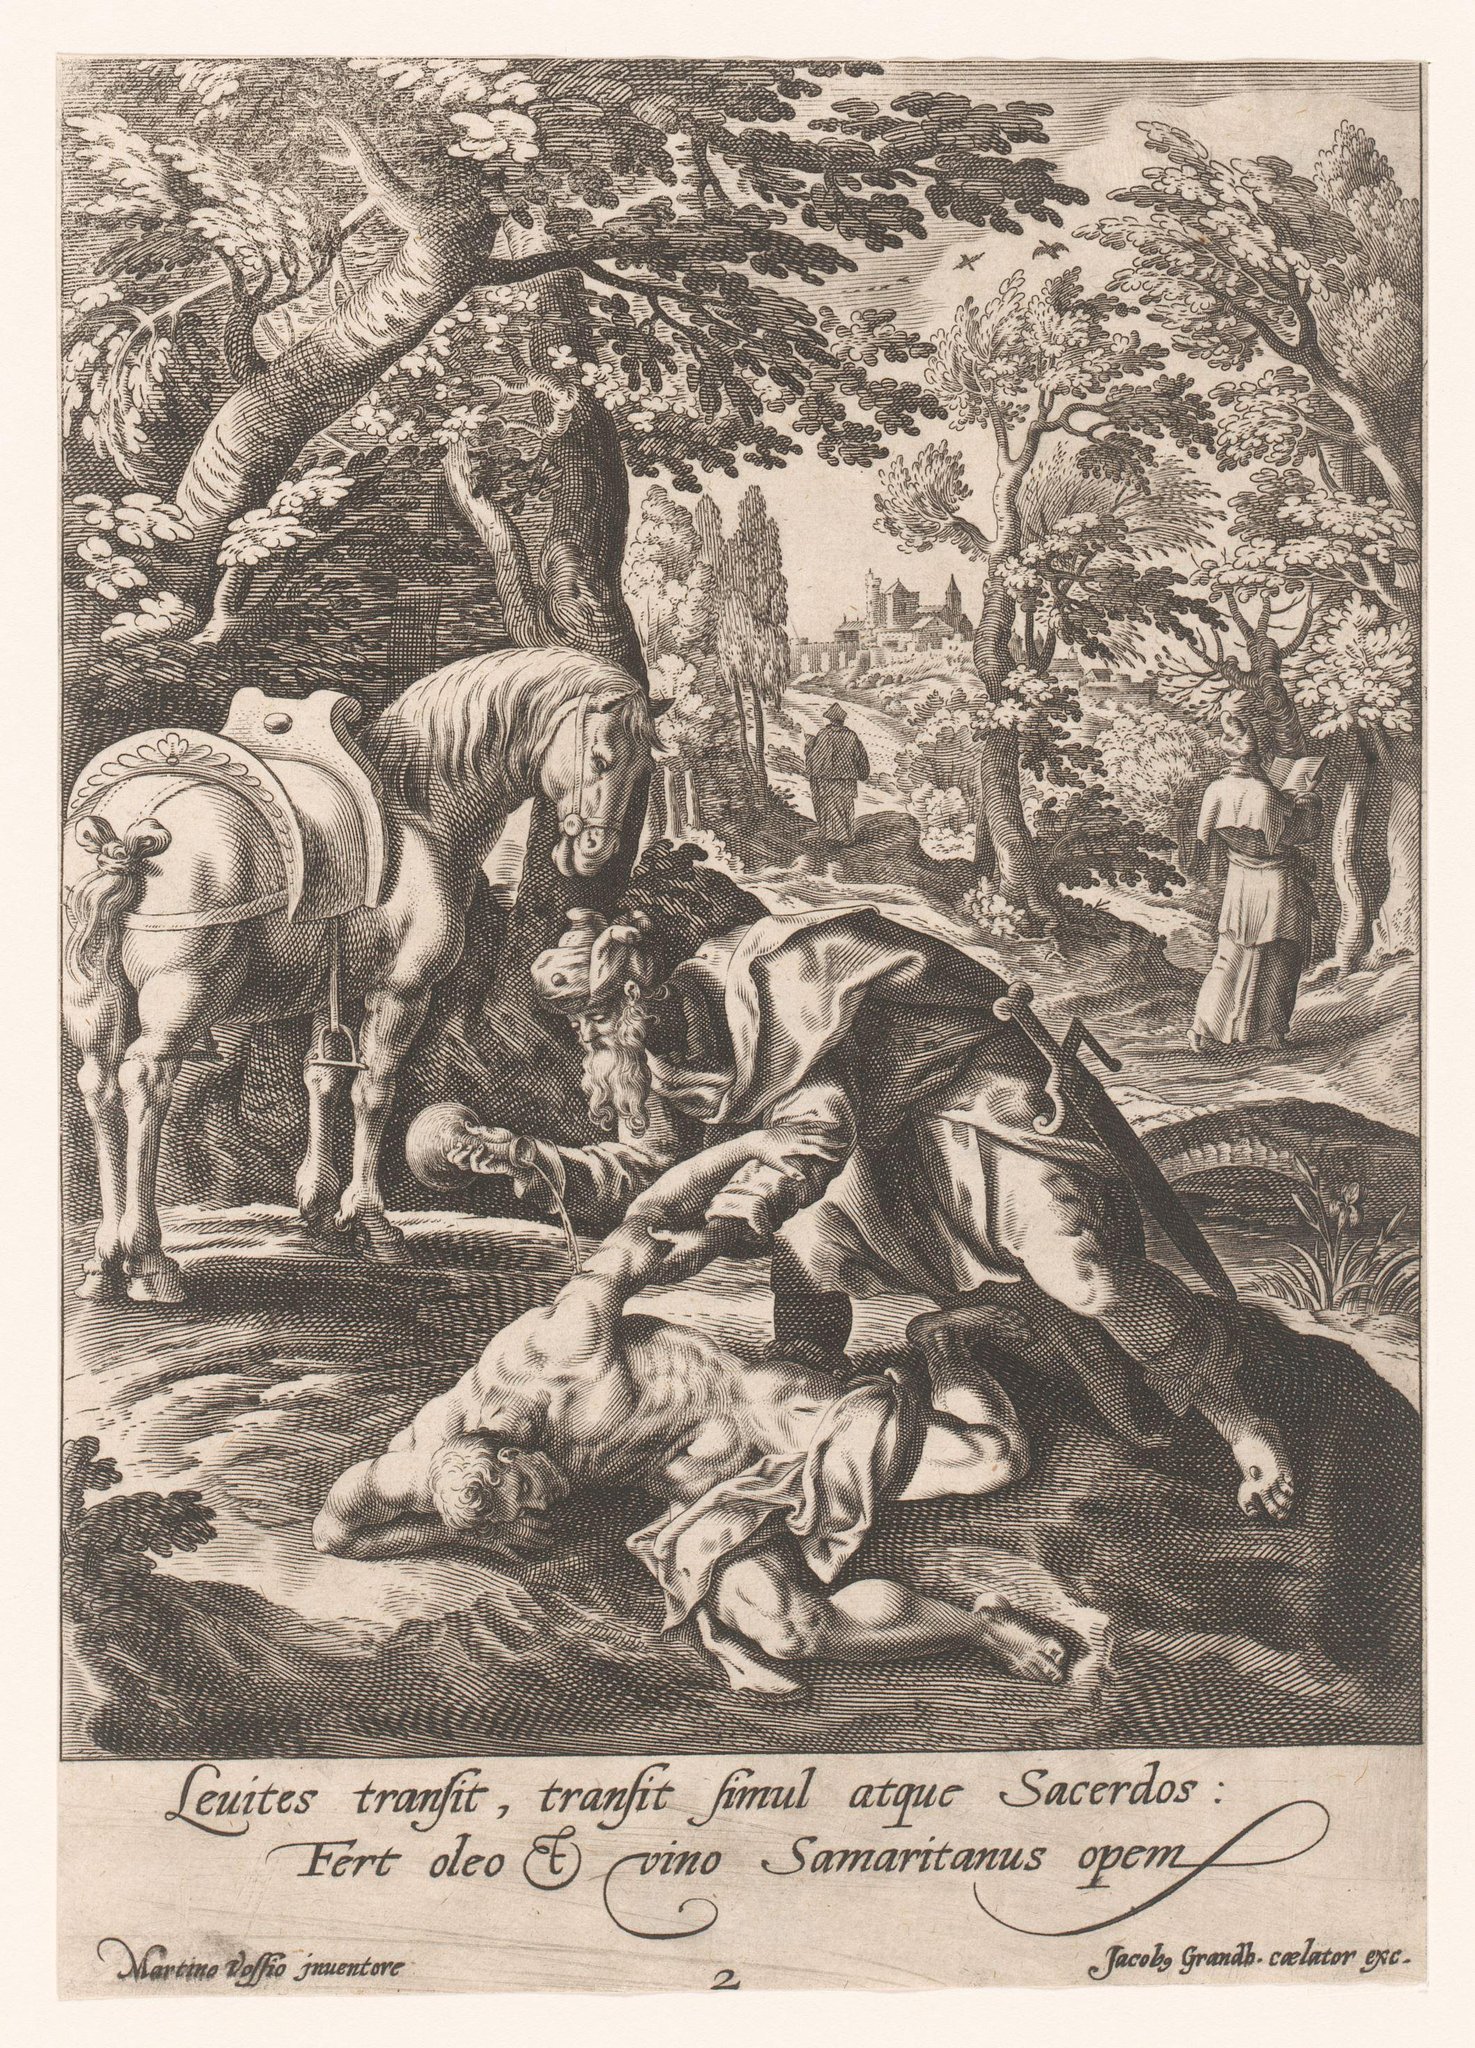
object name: print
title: Gelijkenis van de Barmhartige Samaritaan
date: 1588-1622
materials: paper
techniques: engraving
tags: a priest and/or a levite passing by without attending to the wounded man ~ parable of the good samaritan, a samaritan tending the wounds of the traveller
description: Maakt deel uit van een vierdelige serie met de gelijkenis van de Barmhartige Samaritaan naar Maerten de Vos.